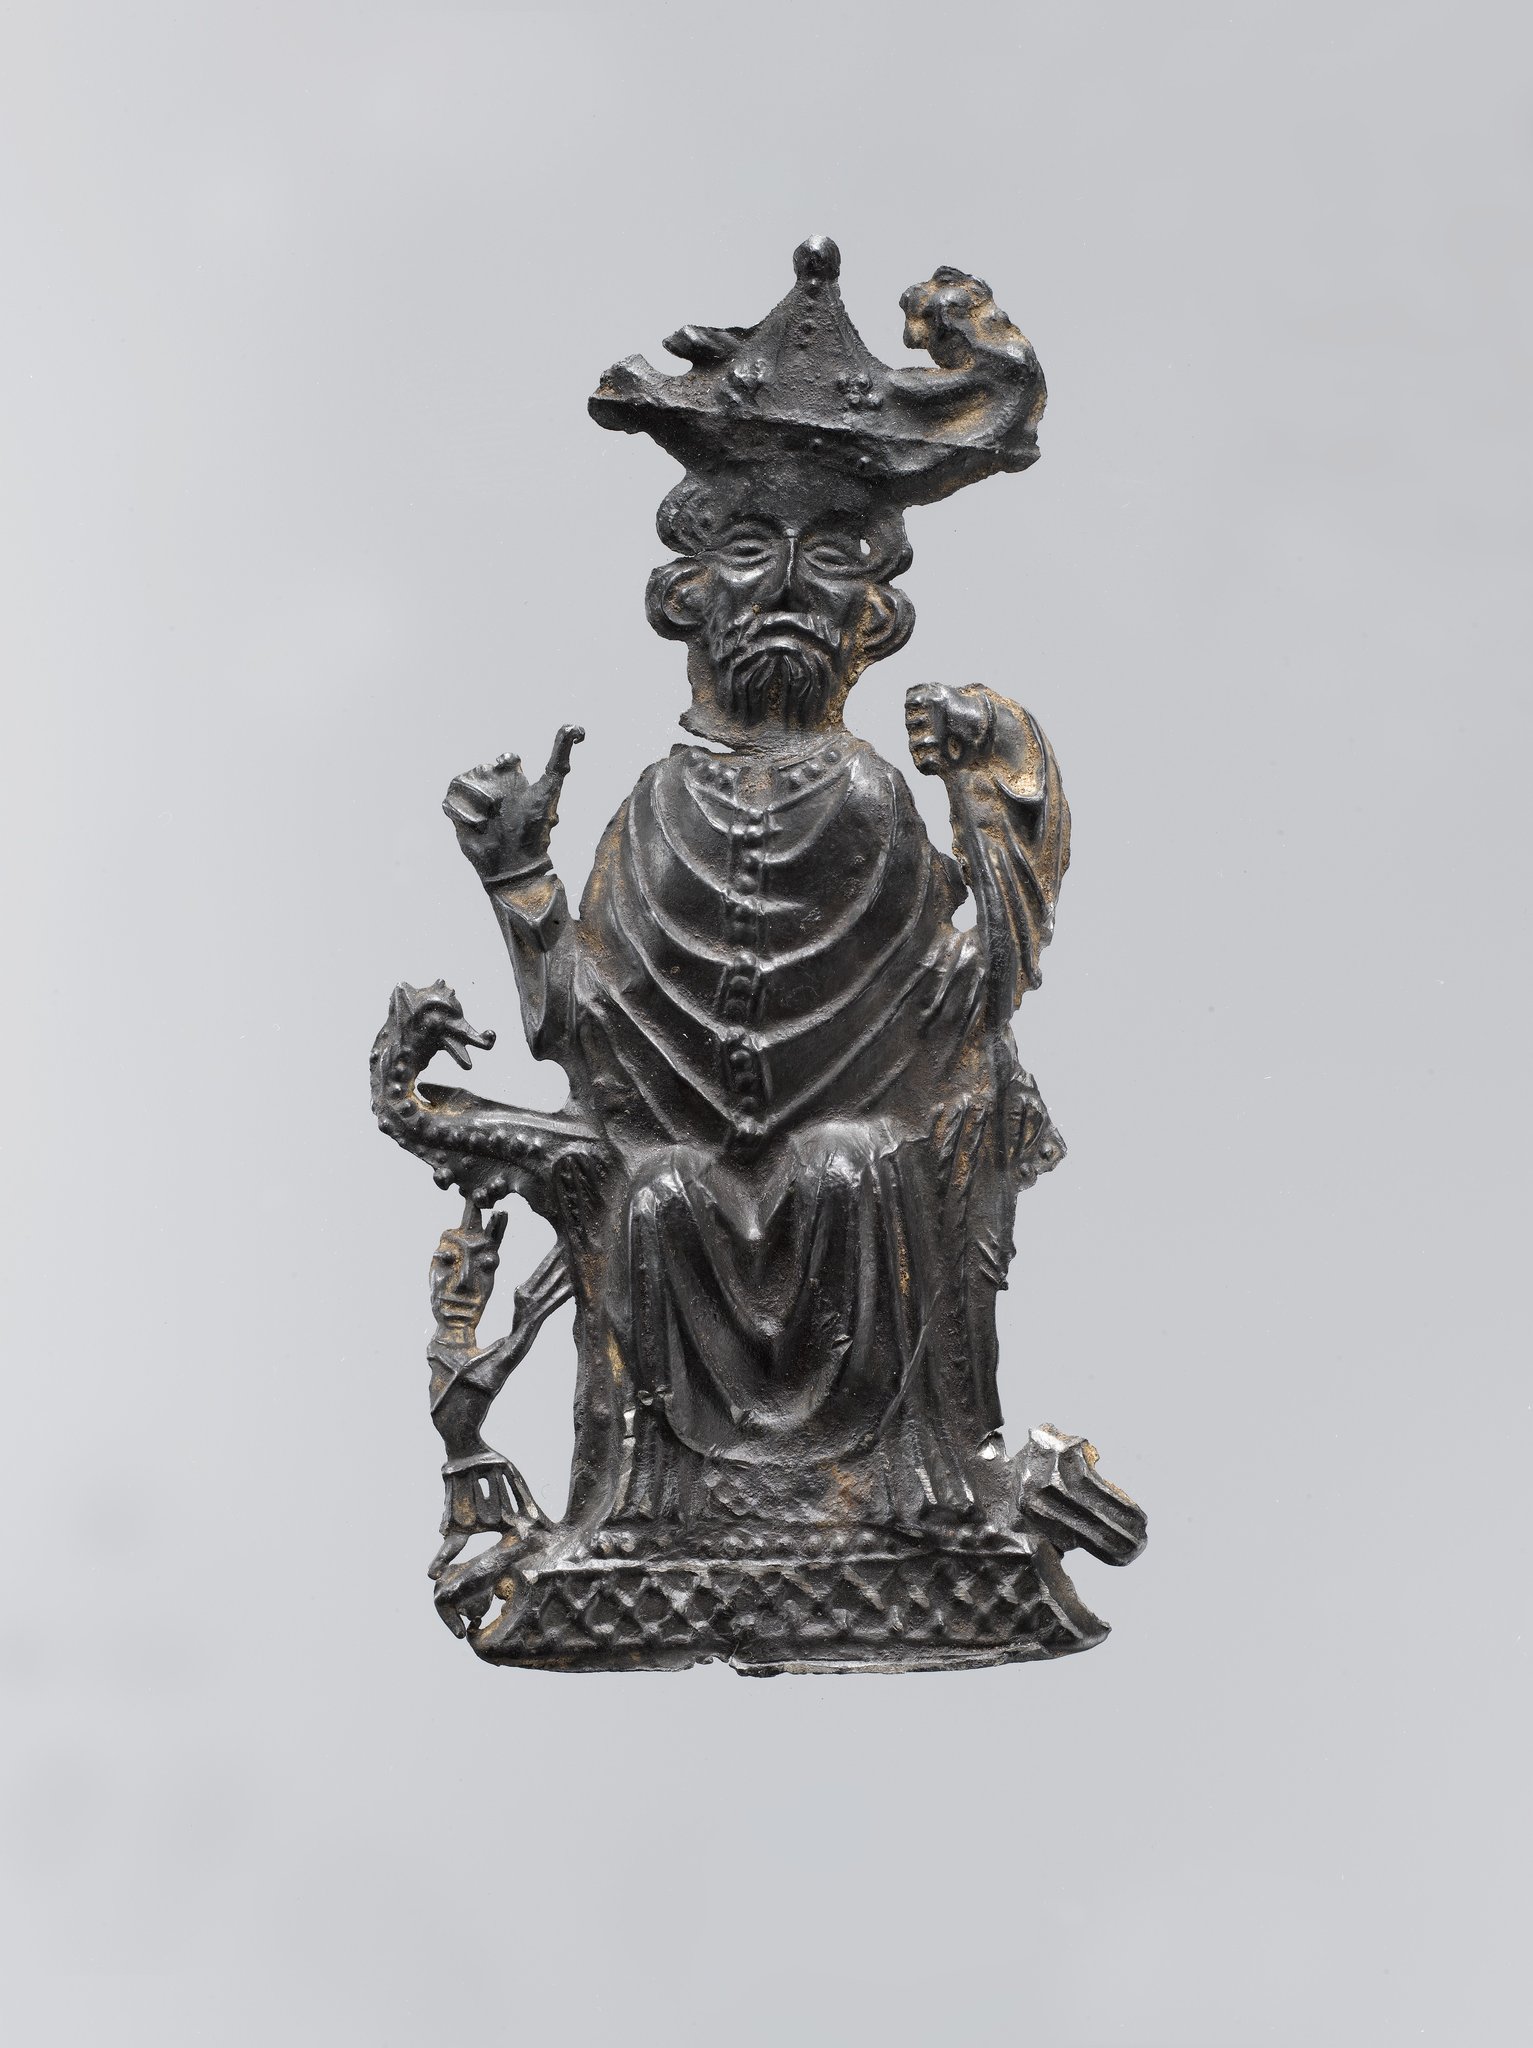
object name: pilgrim's badge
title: Pilgrim's Badge: Saint Theobald of Thann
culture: french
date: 1400-1450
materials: alloy, lead, tin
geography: france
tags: bishops,saints